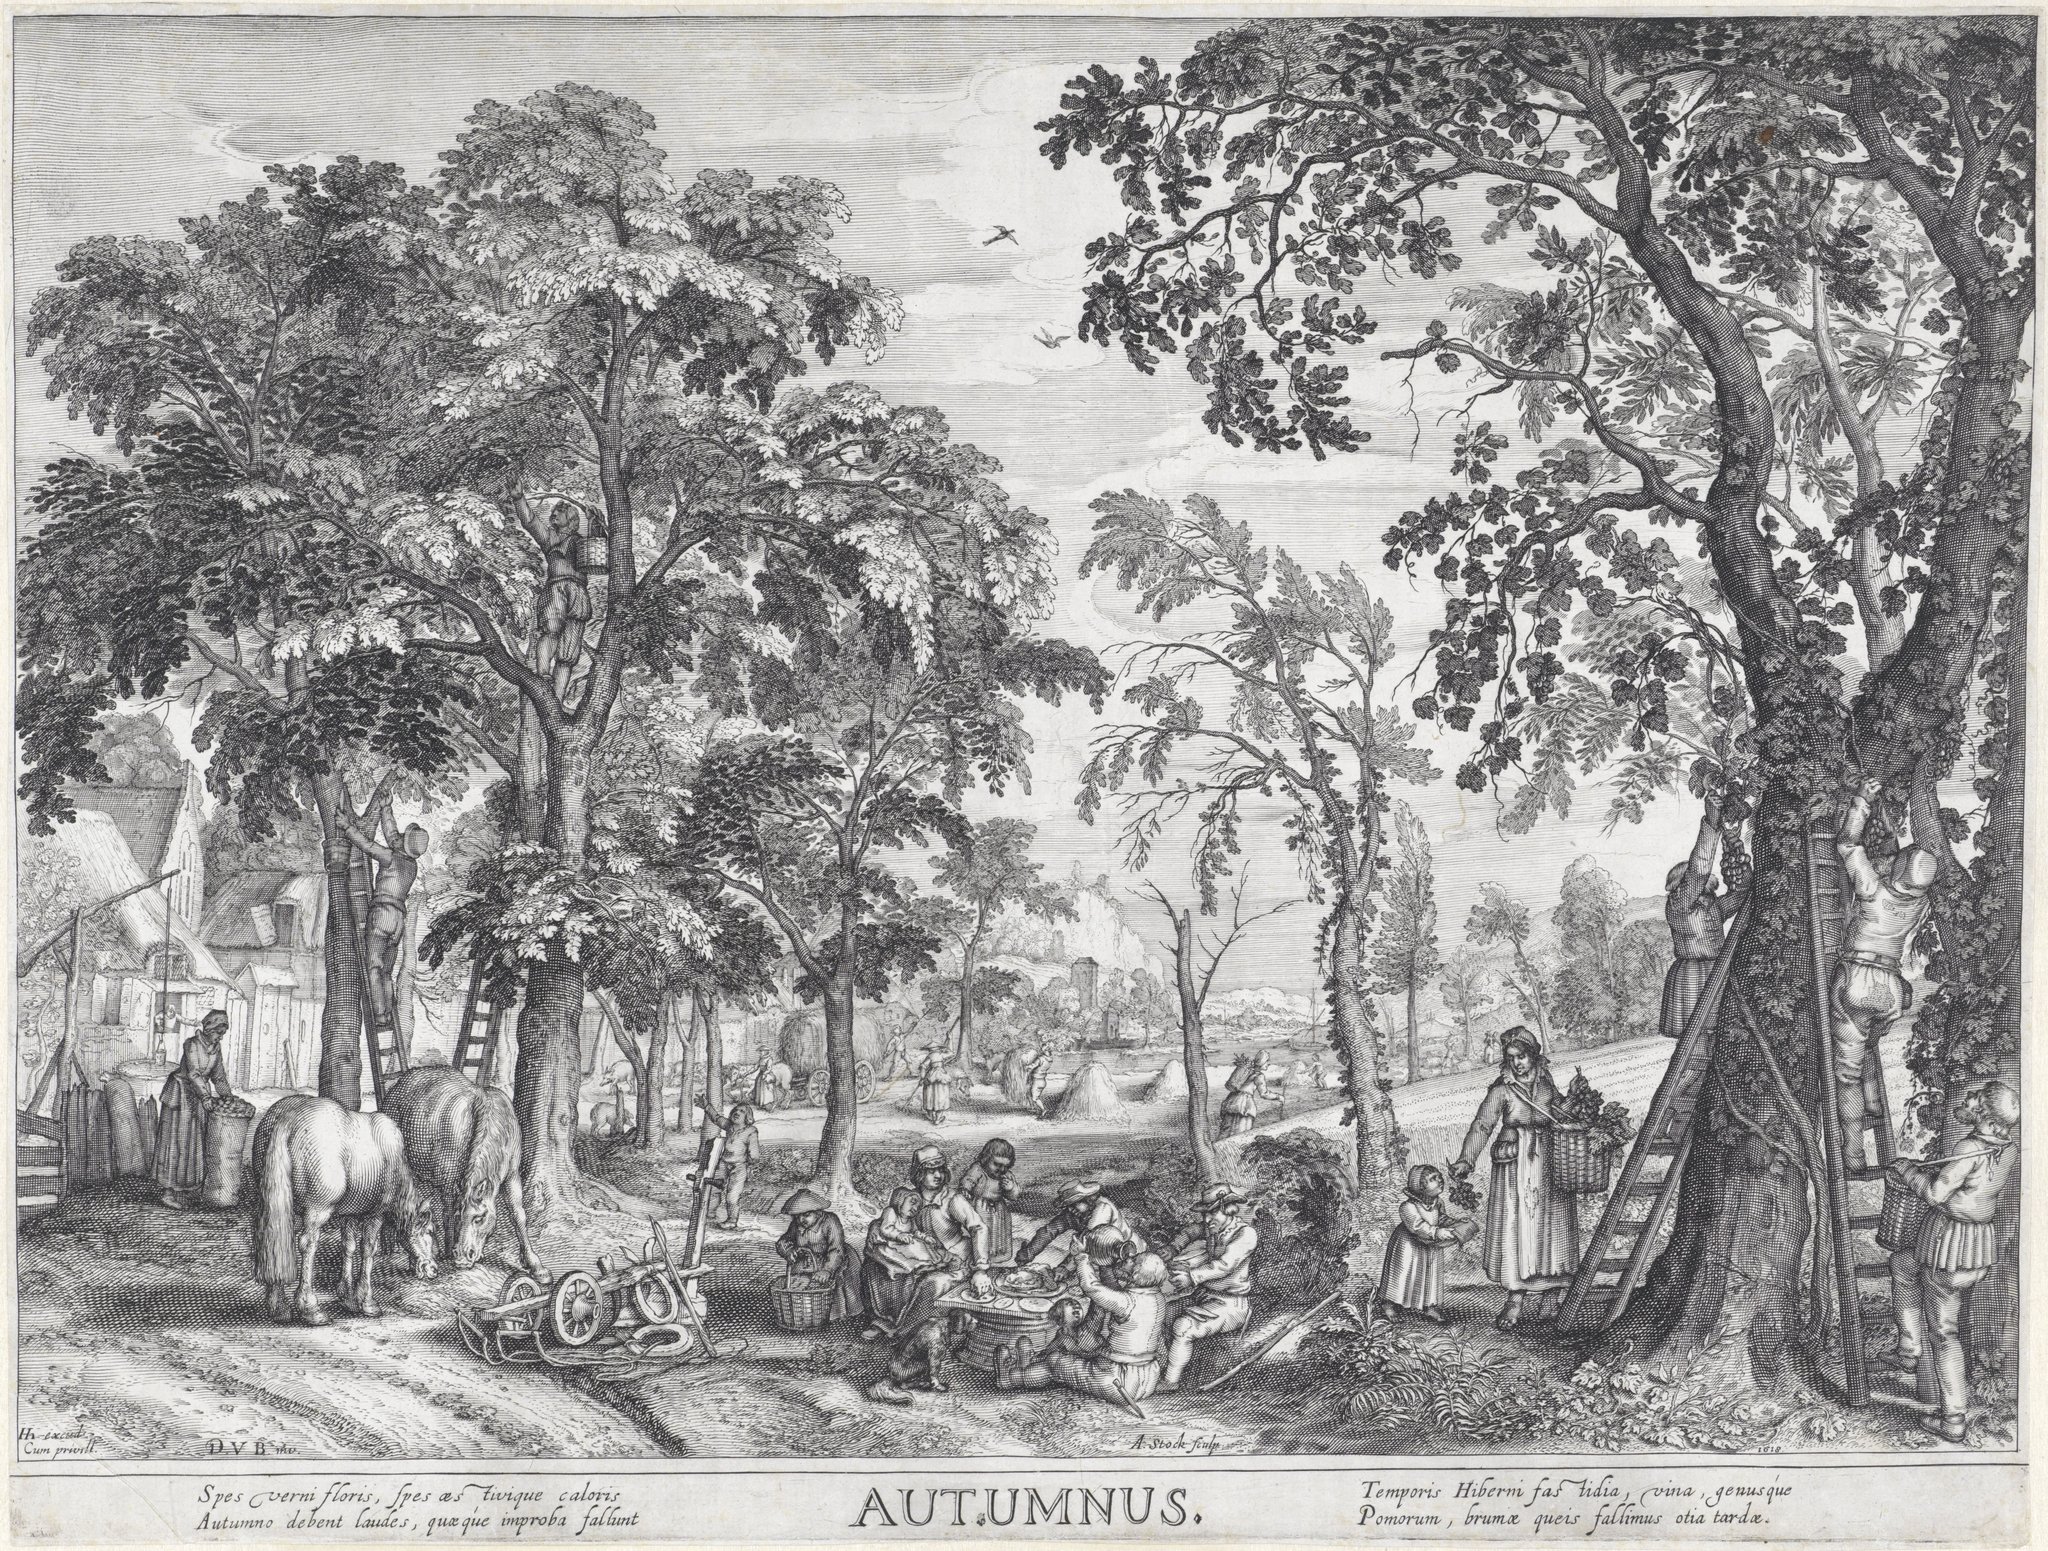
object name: print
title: Herfst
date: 1618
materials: paper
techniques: engraving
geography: the hague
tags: autumn, fall, 'autumnus'; 'autunno' (ripa) (+ with scenes showing human occupations ~ seasons and months)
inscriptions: collector's mark: Lugt 240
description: Landschap met activiteiten die bij de herfst horen. In het midden wordt in de openlucht gegeten. Rechts worden de druiven geoogst. Op de achtergrond hooibalen op het land. Verbeelding van het seizoen herfst. Prent uit een serie van vier seizoenen.